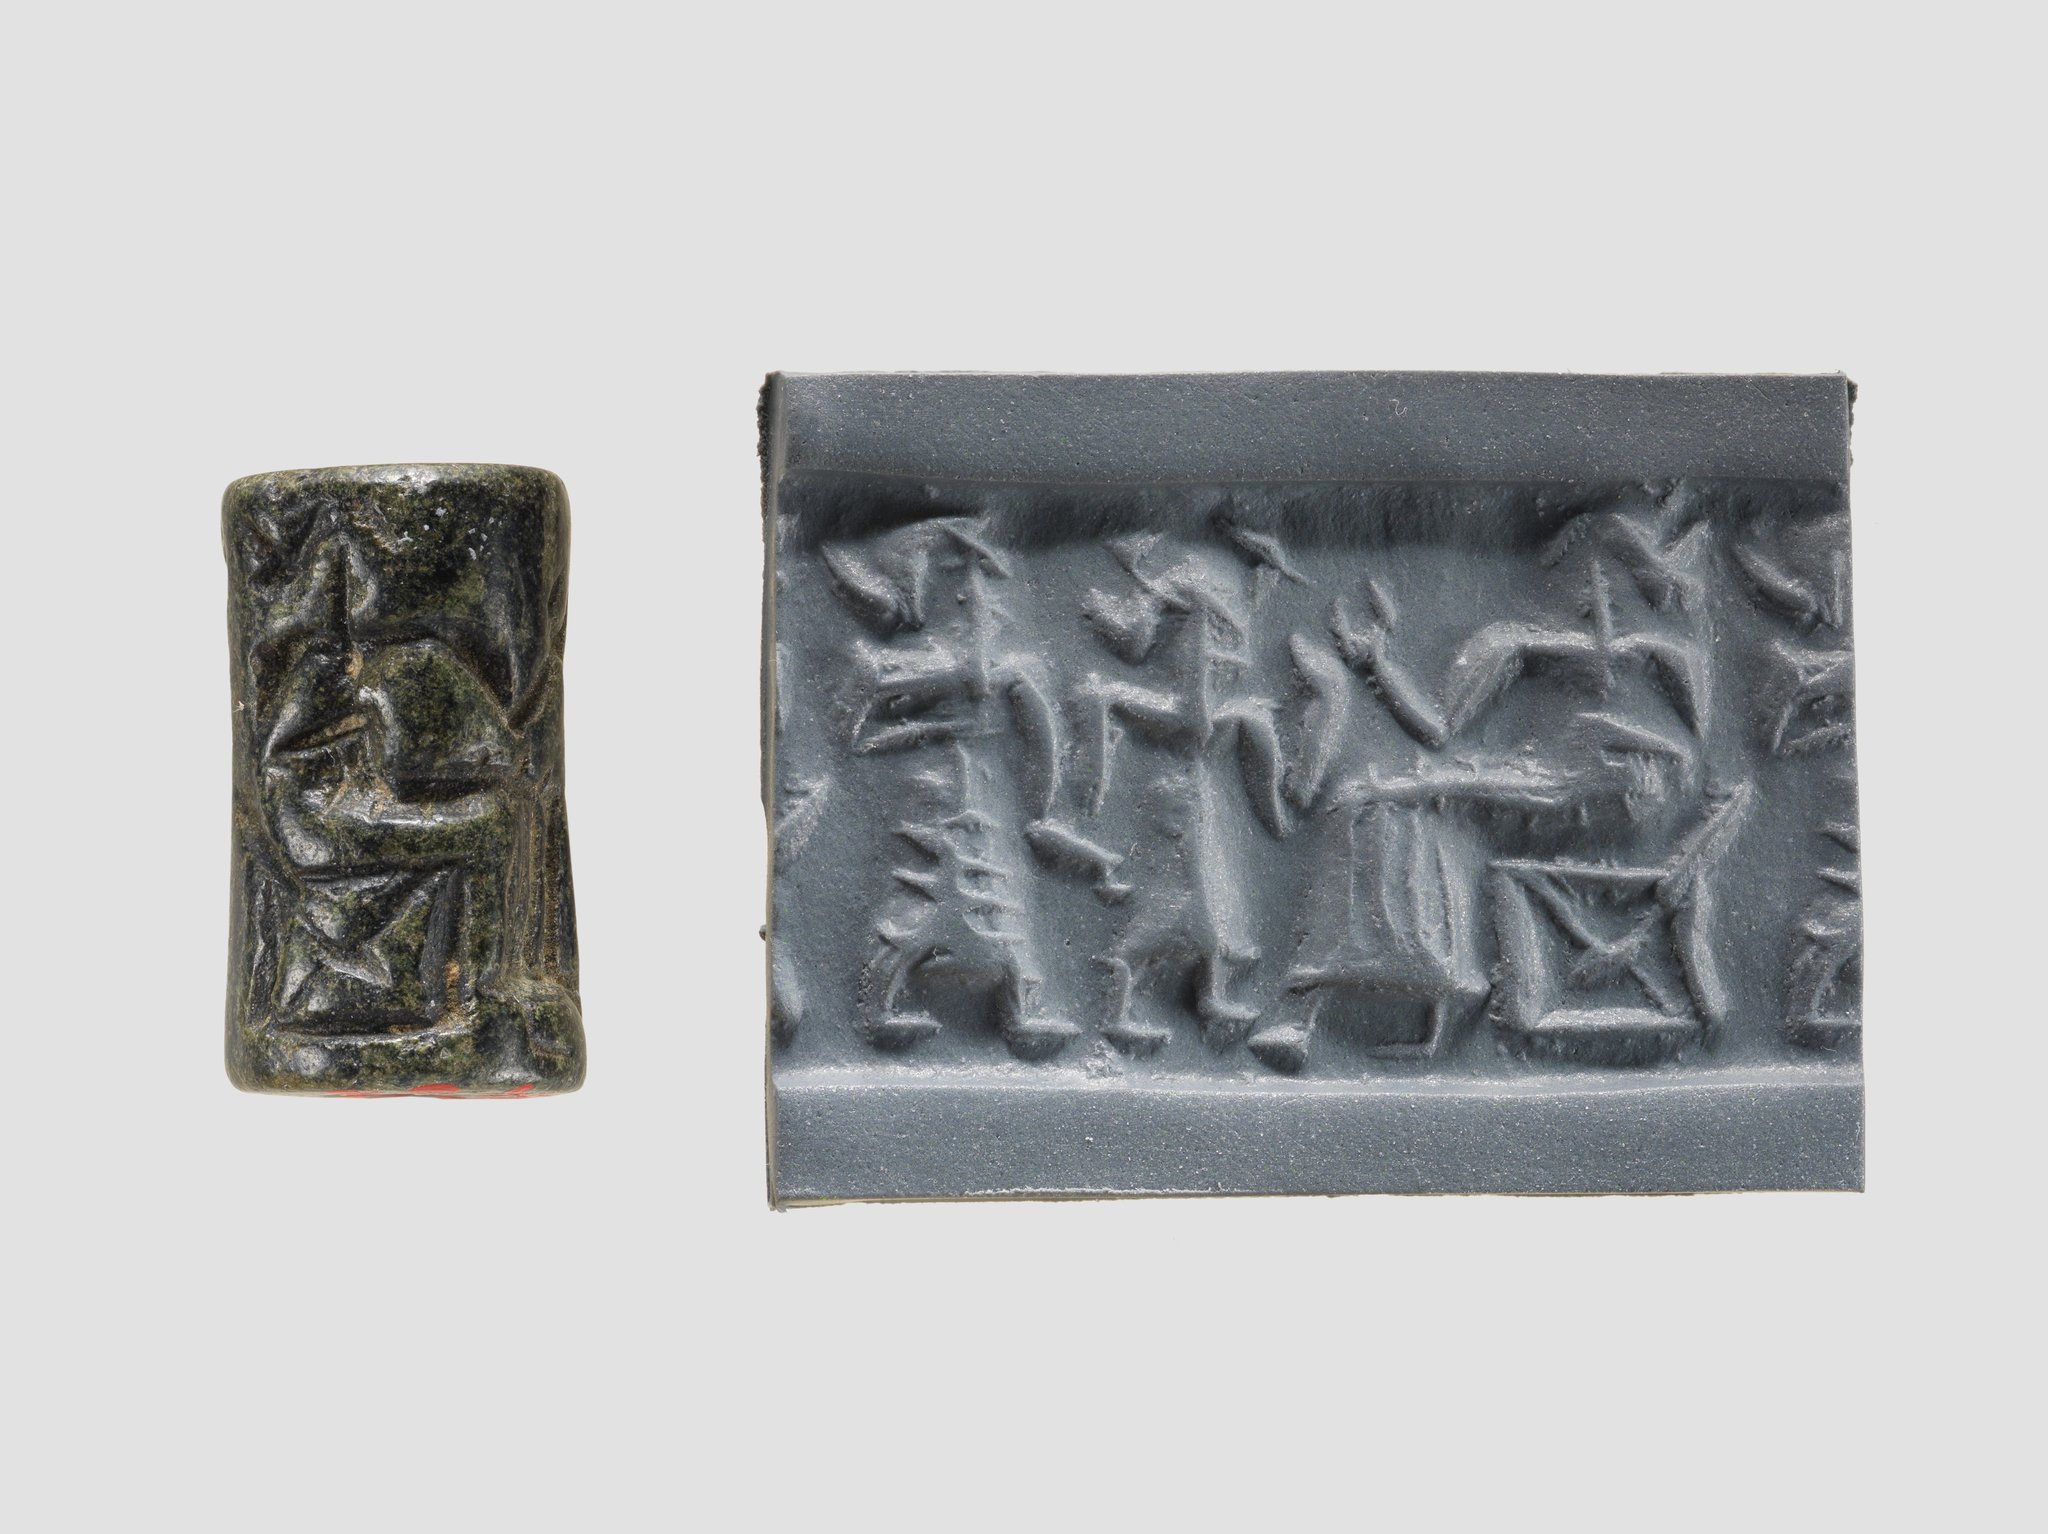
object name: cylinder seal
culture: isin-larsa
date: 2000-1750 BCE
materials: stone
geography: mesopotamia